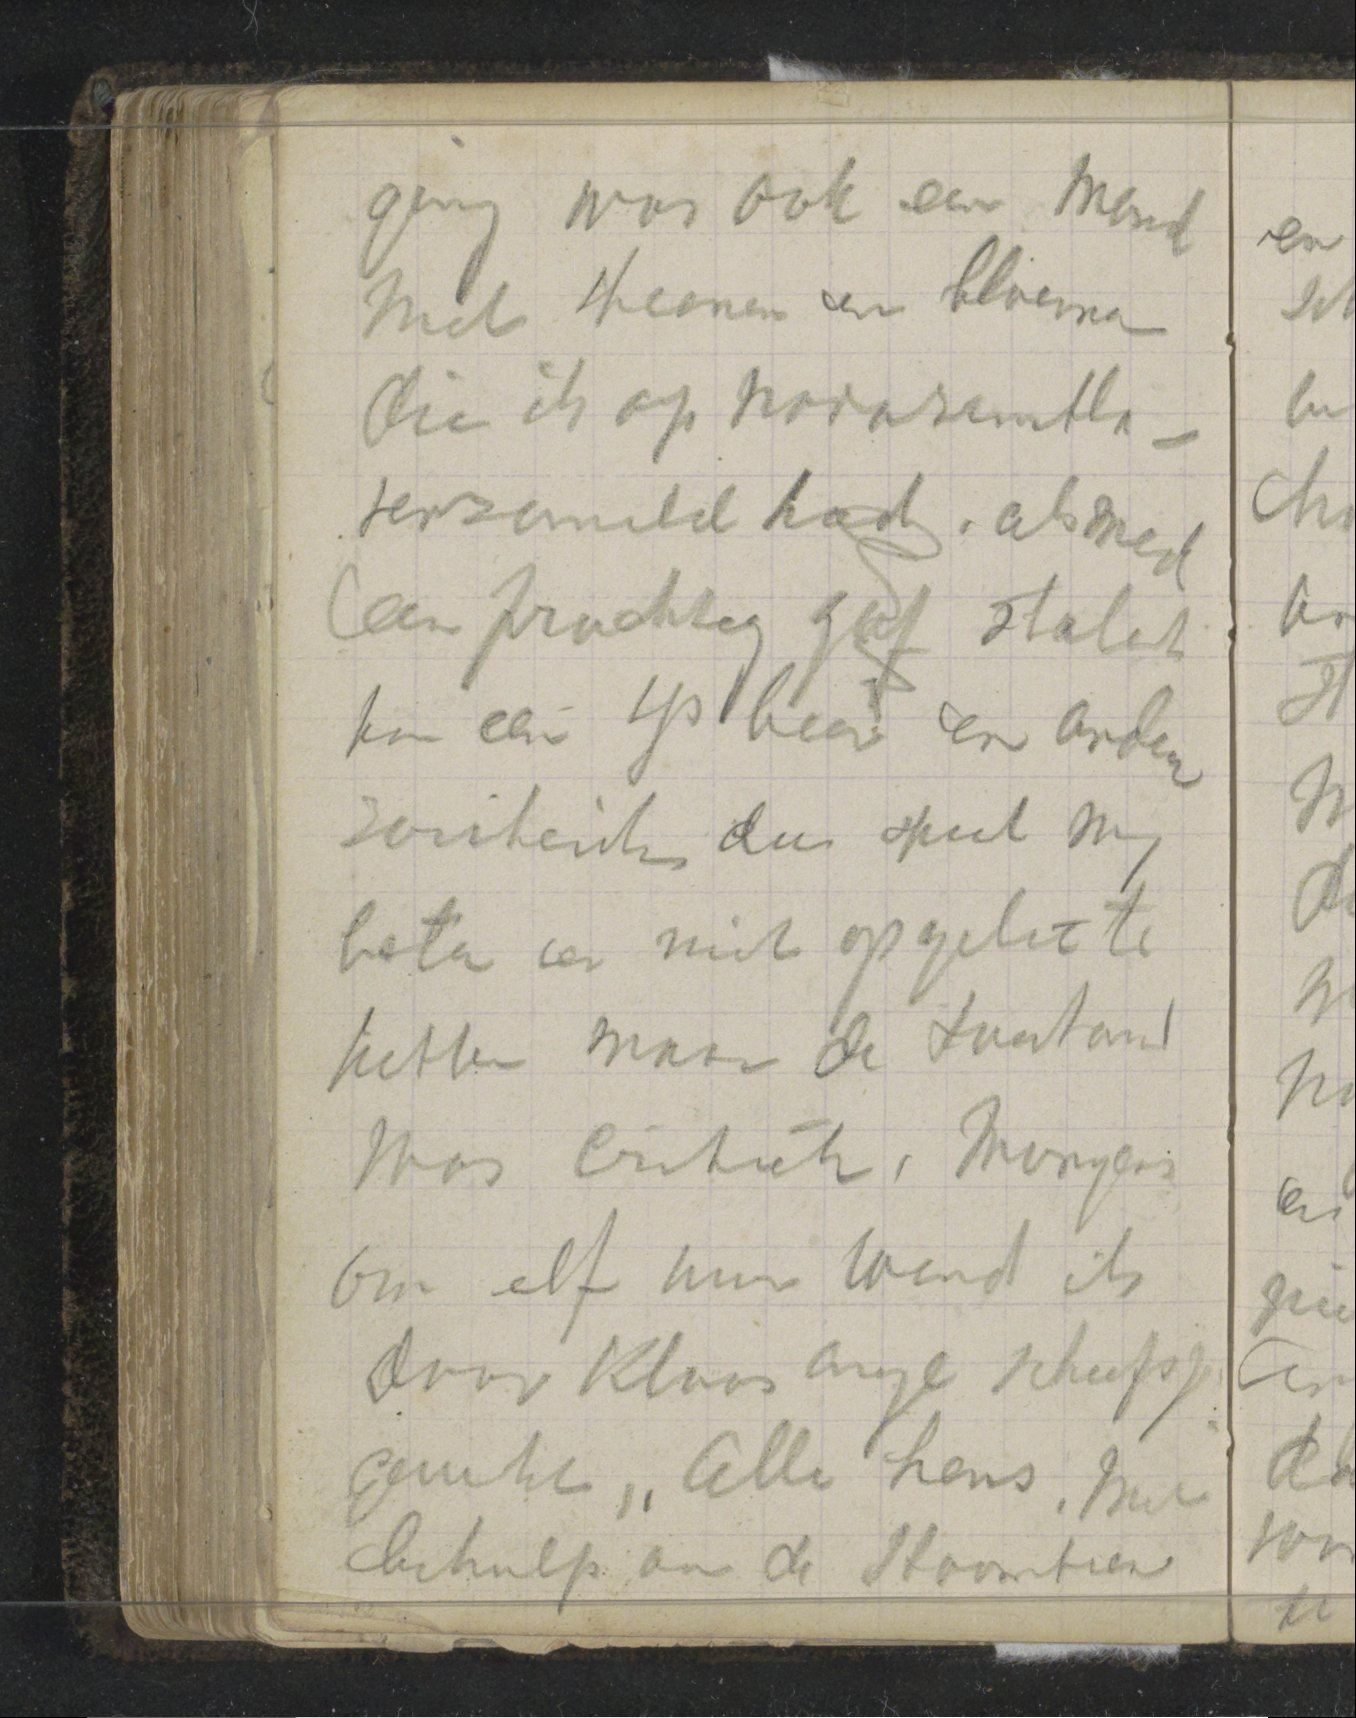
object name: sketchbook leaf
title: Reisverslag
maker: louis apol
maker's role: draughtsman, painter, print maker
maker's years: 1850-1936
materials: pencil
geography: novaya zemlya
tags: nova zembla expedities 1880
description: Blad 95 verso uit een schetsboek met 110 bladen betekend tijdens de expeditie naar Nova Zembla in 1880.